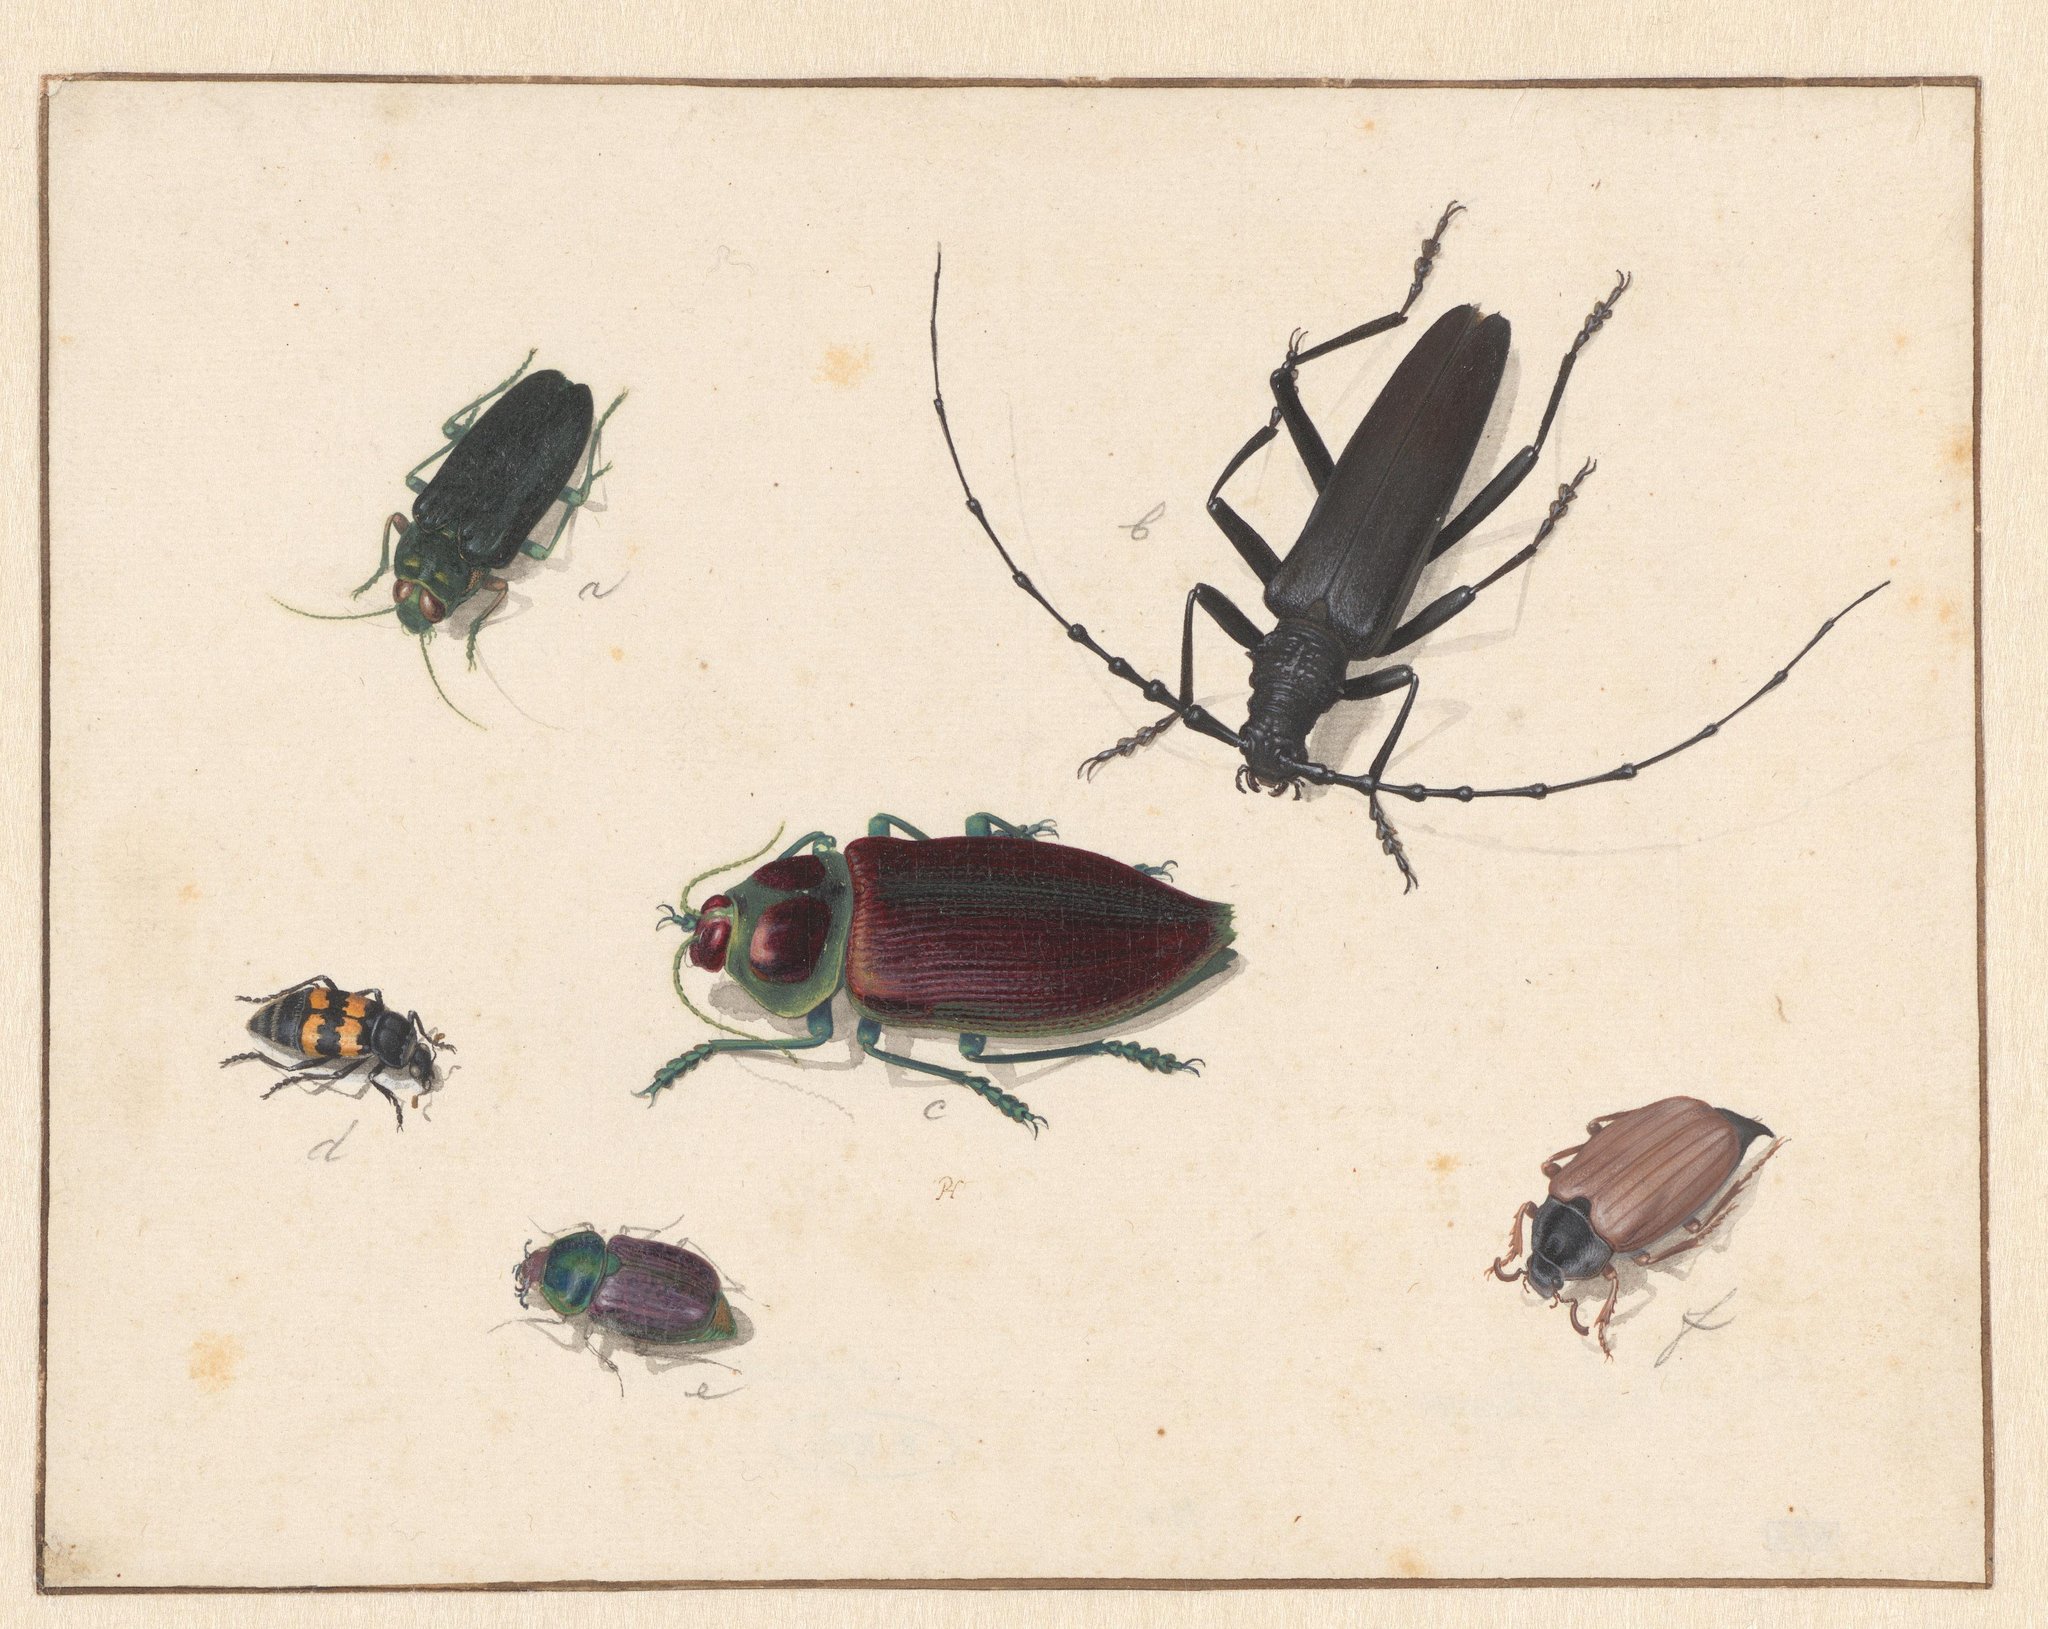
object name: drawing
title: Sheet with six beetles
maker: pieter holsteyn (i)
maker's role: draughtsman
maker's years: 1580-1662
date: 1620-1662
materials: gouache, paper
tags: insects: beetle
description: Pieter Holsteyn grouped six different species of beetles like precious jewels on the sheet of paper. He beautifully captured the metallic sheen of their ‘armour.’ Such nature studies were earmarked as having been made naer het leven or ad vivum, ‘from life.’ However, that should not be taken too literally in this case. He probably drew dead specimens. After all, insects are impatient models: they do not care to stay still.